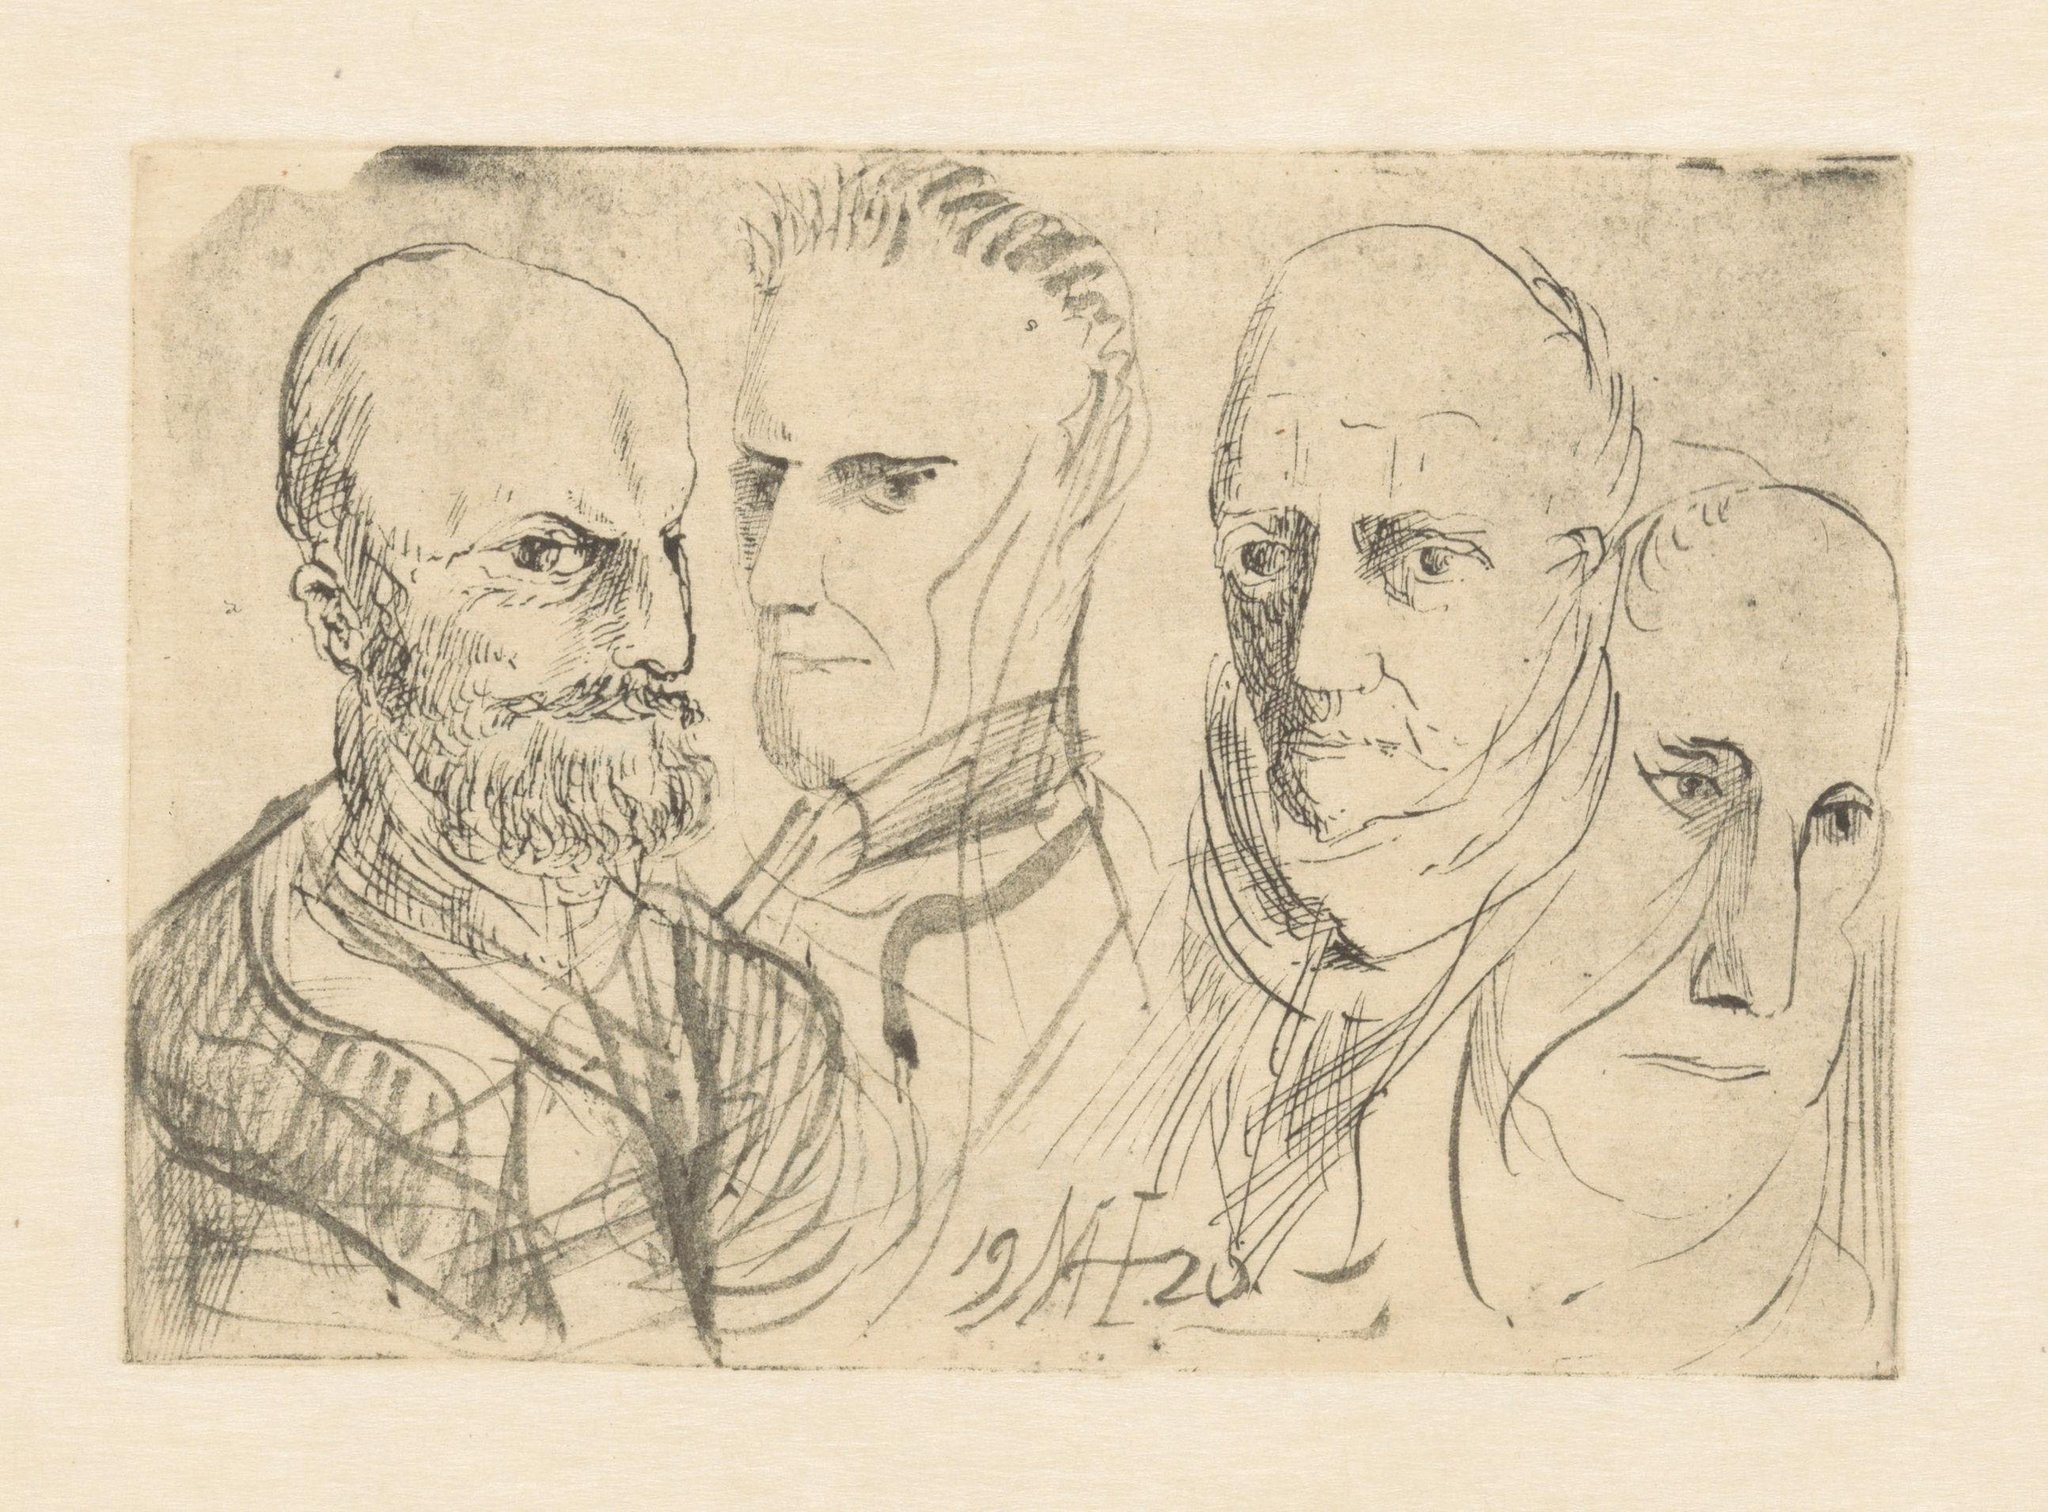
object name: print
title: Vier mannen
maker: marius holleman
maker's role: draughtsman, print maker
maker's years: 1878-1926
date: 1920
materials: paper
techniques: etching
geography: groningen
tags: baldness, beard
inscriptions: collector's mark: Lugt 2228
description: De rechter man heeft een kaal hoofd en een baard.